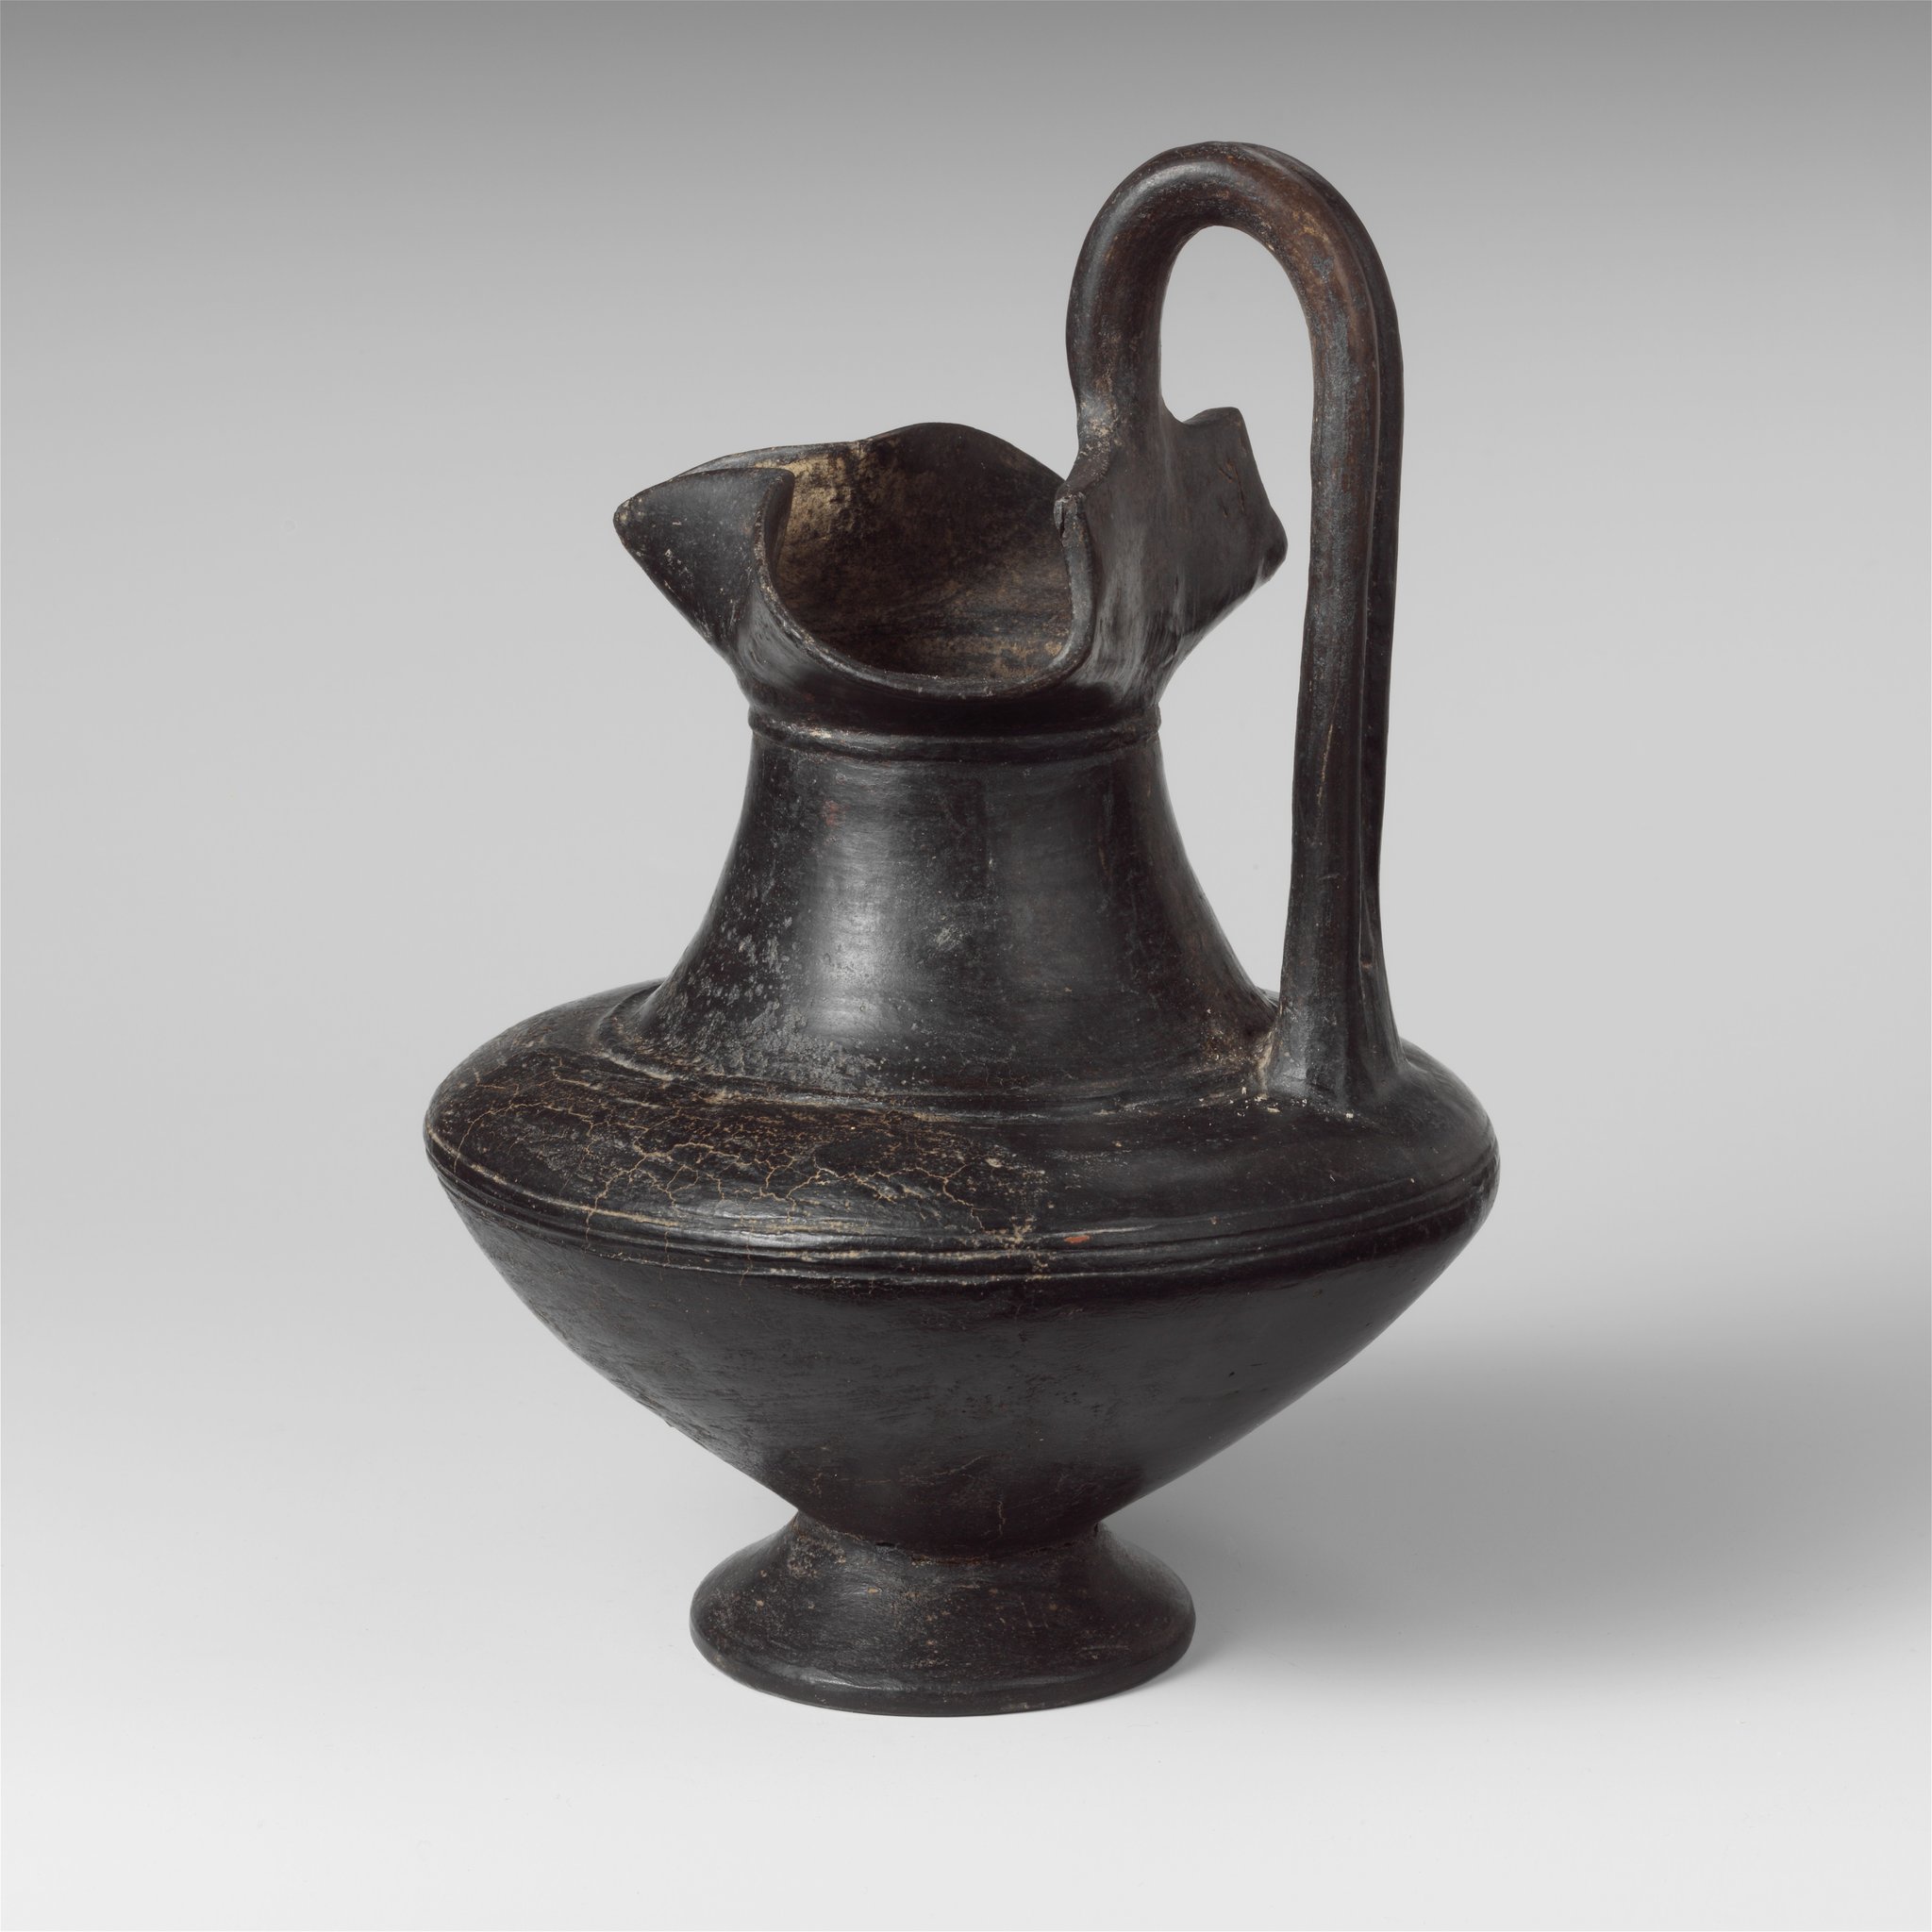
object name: oinochoe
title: Terracotta oinochoe (jug)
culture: etruscan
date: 600-501 BCE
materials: terracotta